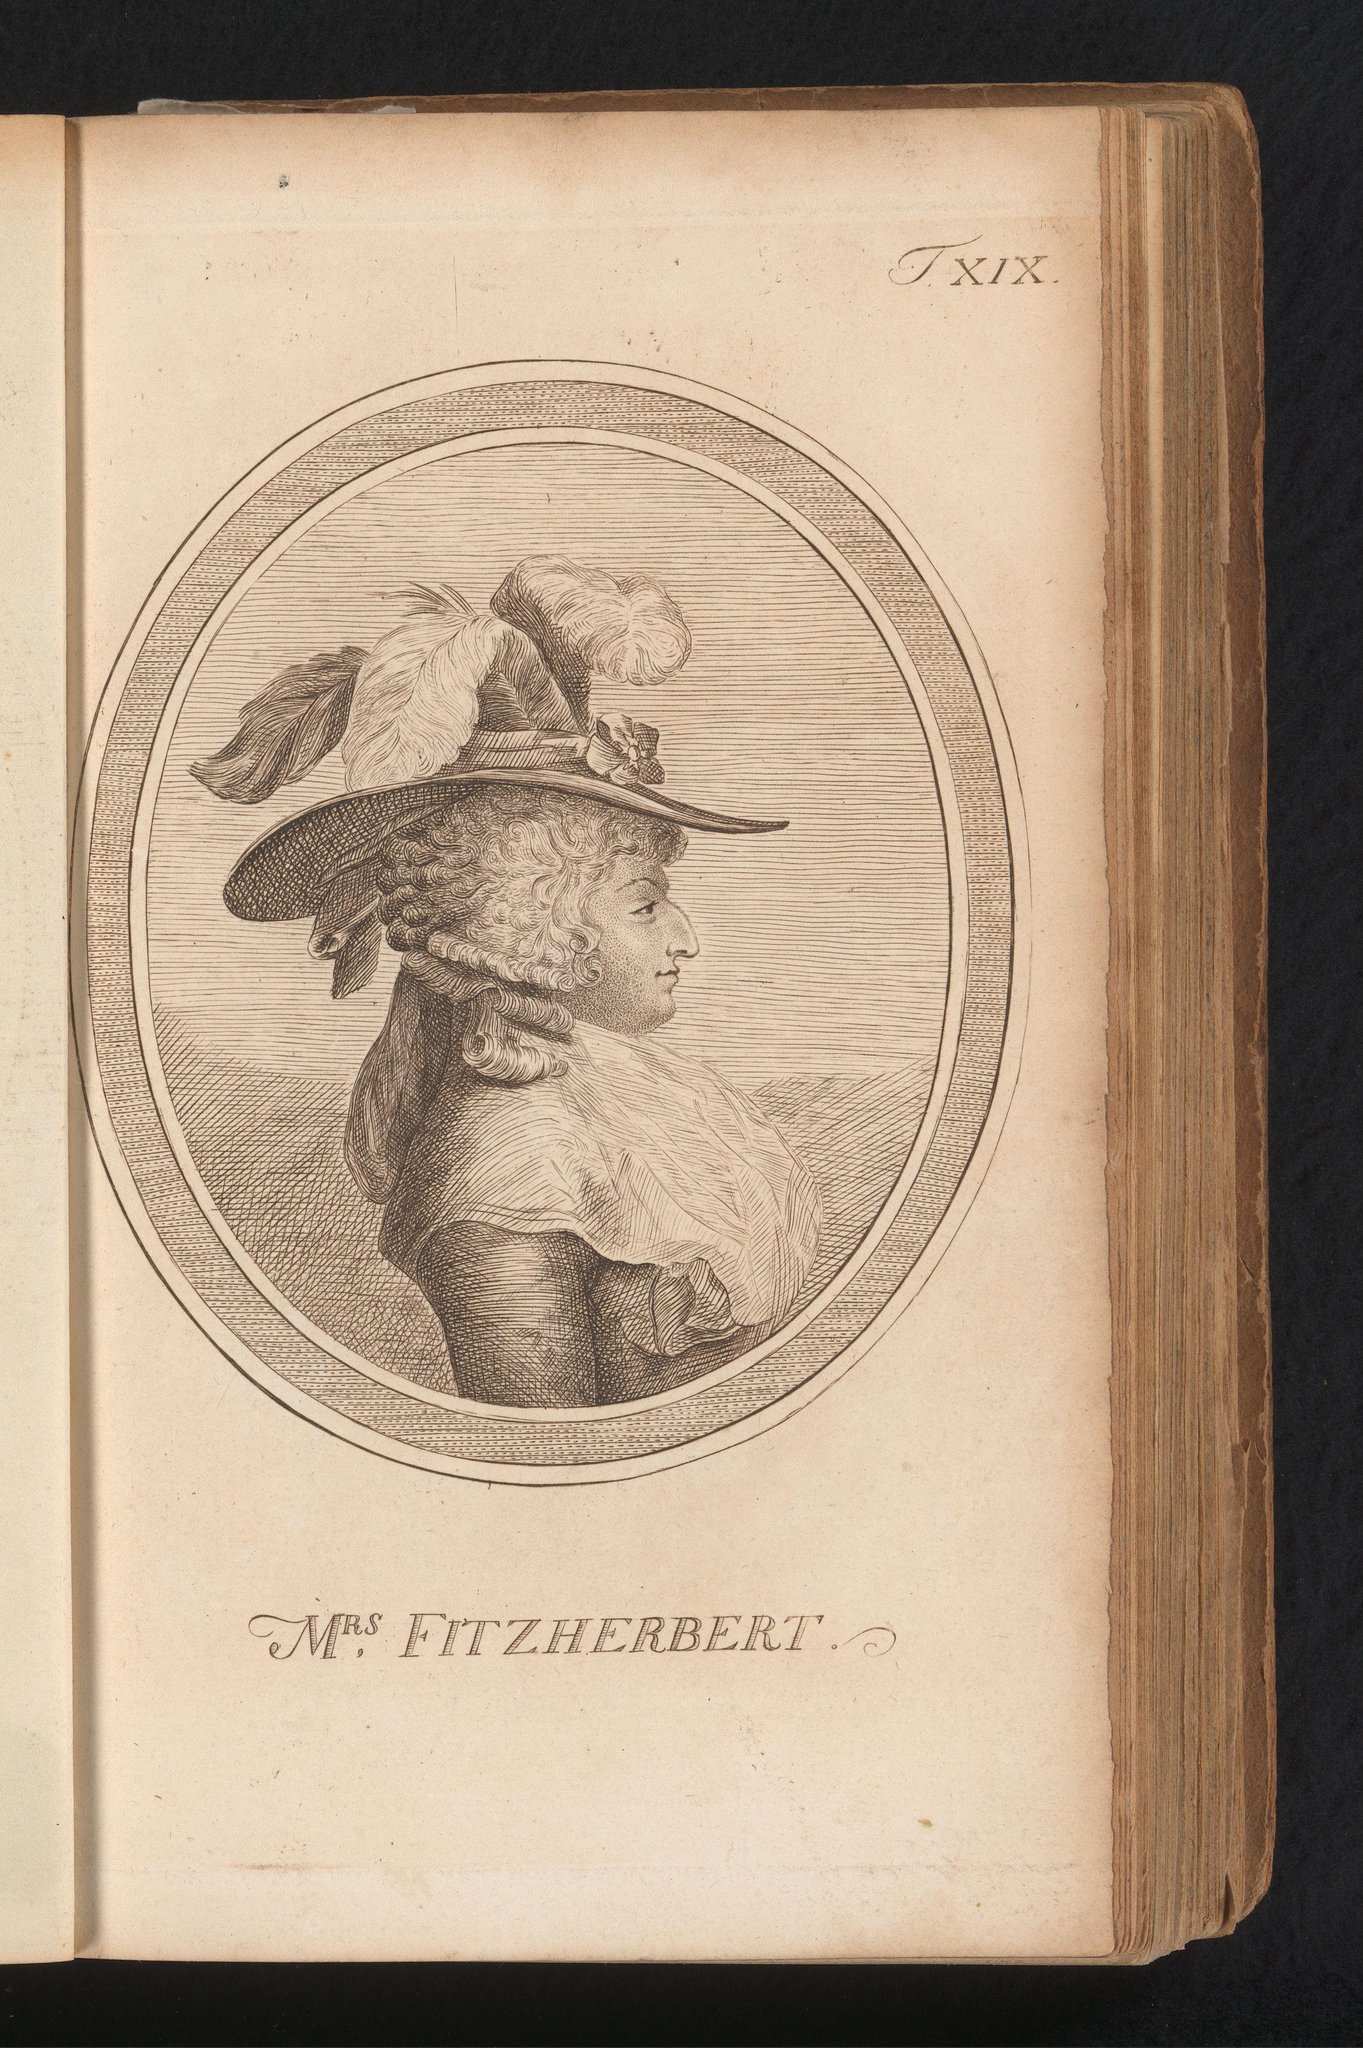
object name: fashion print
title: Journal des Luxus und der Moden 1786, Band I, T. 19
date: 1786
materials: paper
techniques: etching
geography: weimar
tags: fashion plates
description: Portret van Mrs. Fitzherbert,: buste naarcrechts,in ovaal. Prent uit het modetijdschrift Journal des Luxus und der Moden, uitgegeven door Friedrich Justin Bertuch en Georg Melchior Kraus, Weimar, 1786-1826.